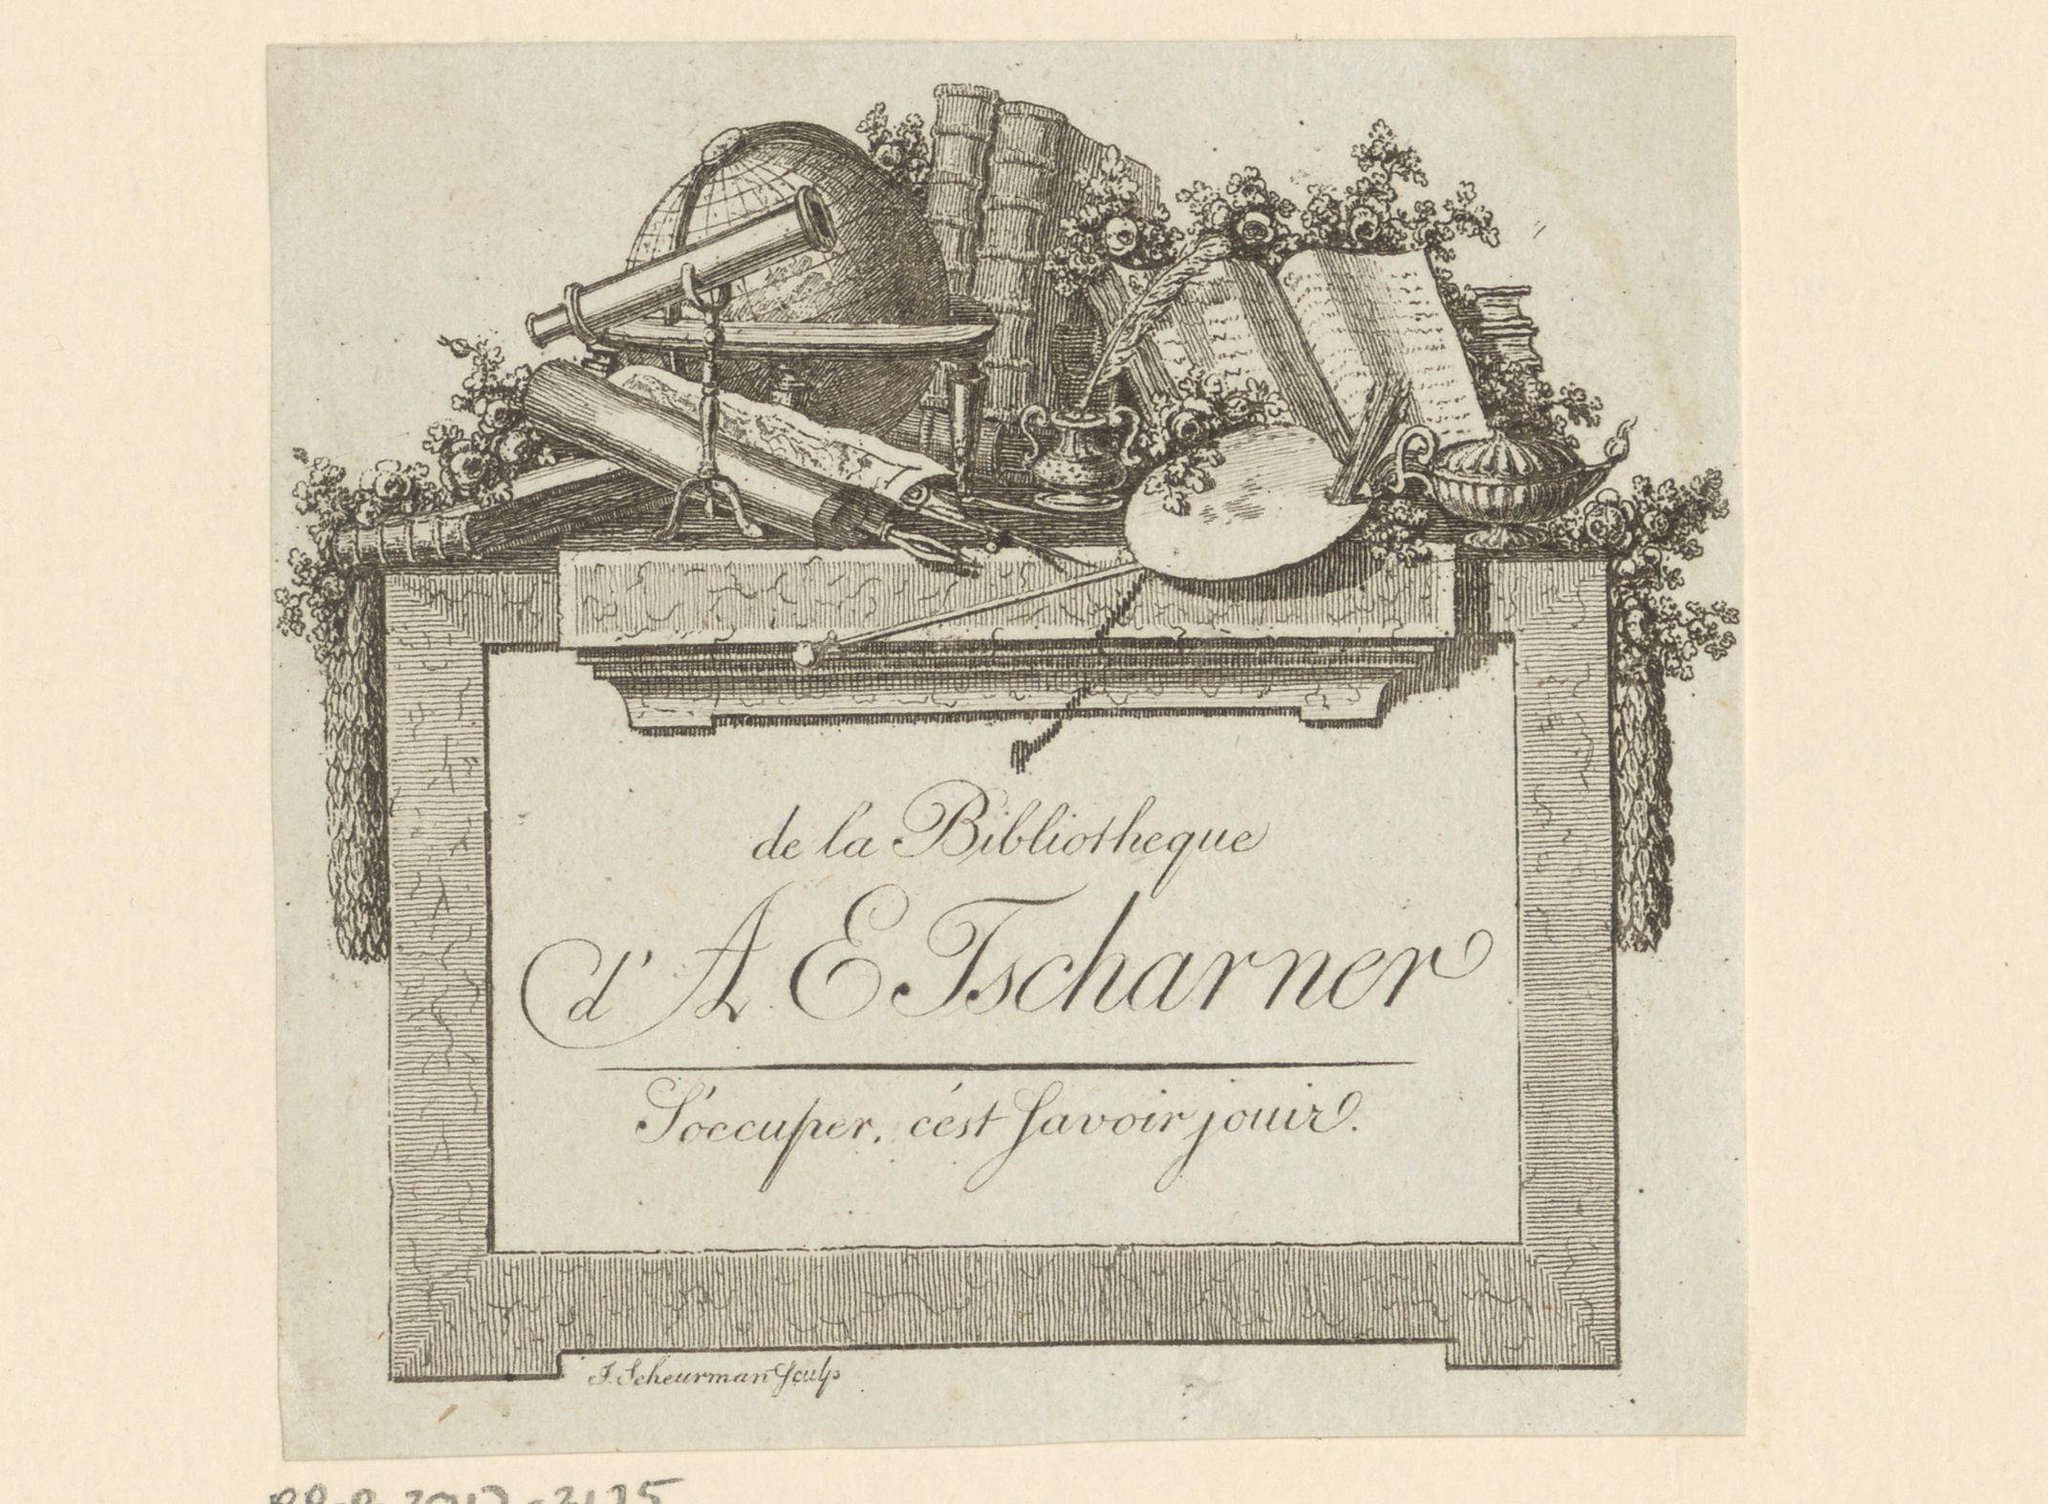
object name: bookplate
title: S'occuper, c'est savoir jouir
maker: samuel johann jakob scheuermann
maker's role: print maker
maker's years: 1770-1844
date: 1780-1844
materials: paper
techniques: etching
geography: switzerland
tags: book, oil-lamp, telescope, edifice, e.g.: public building, department store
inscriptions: collector's mark: Lugt 2760